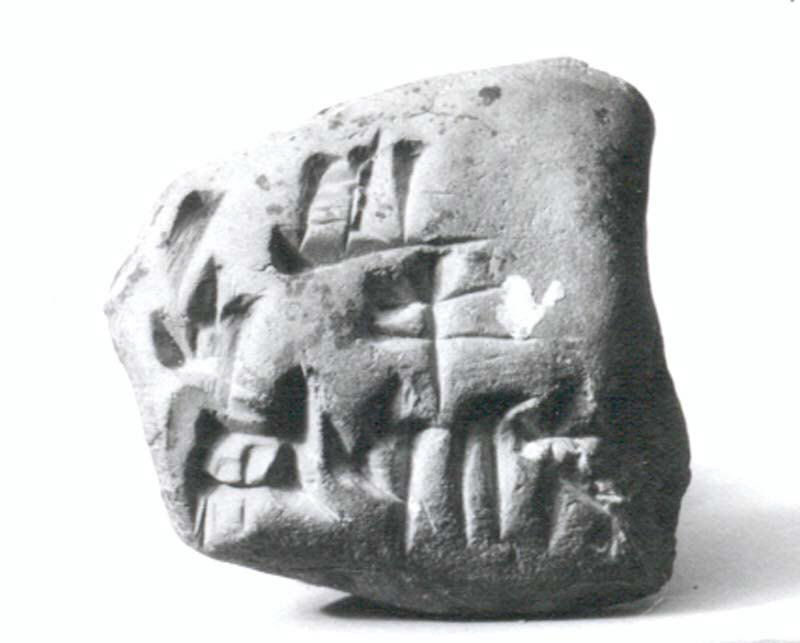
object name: cuneiform tablet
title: Cuneiform tablet: label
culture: babylonian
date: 2000-1501 BCE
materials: clay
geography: mesopotamia